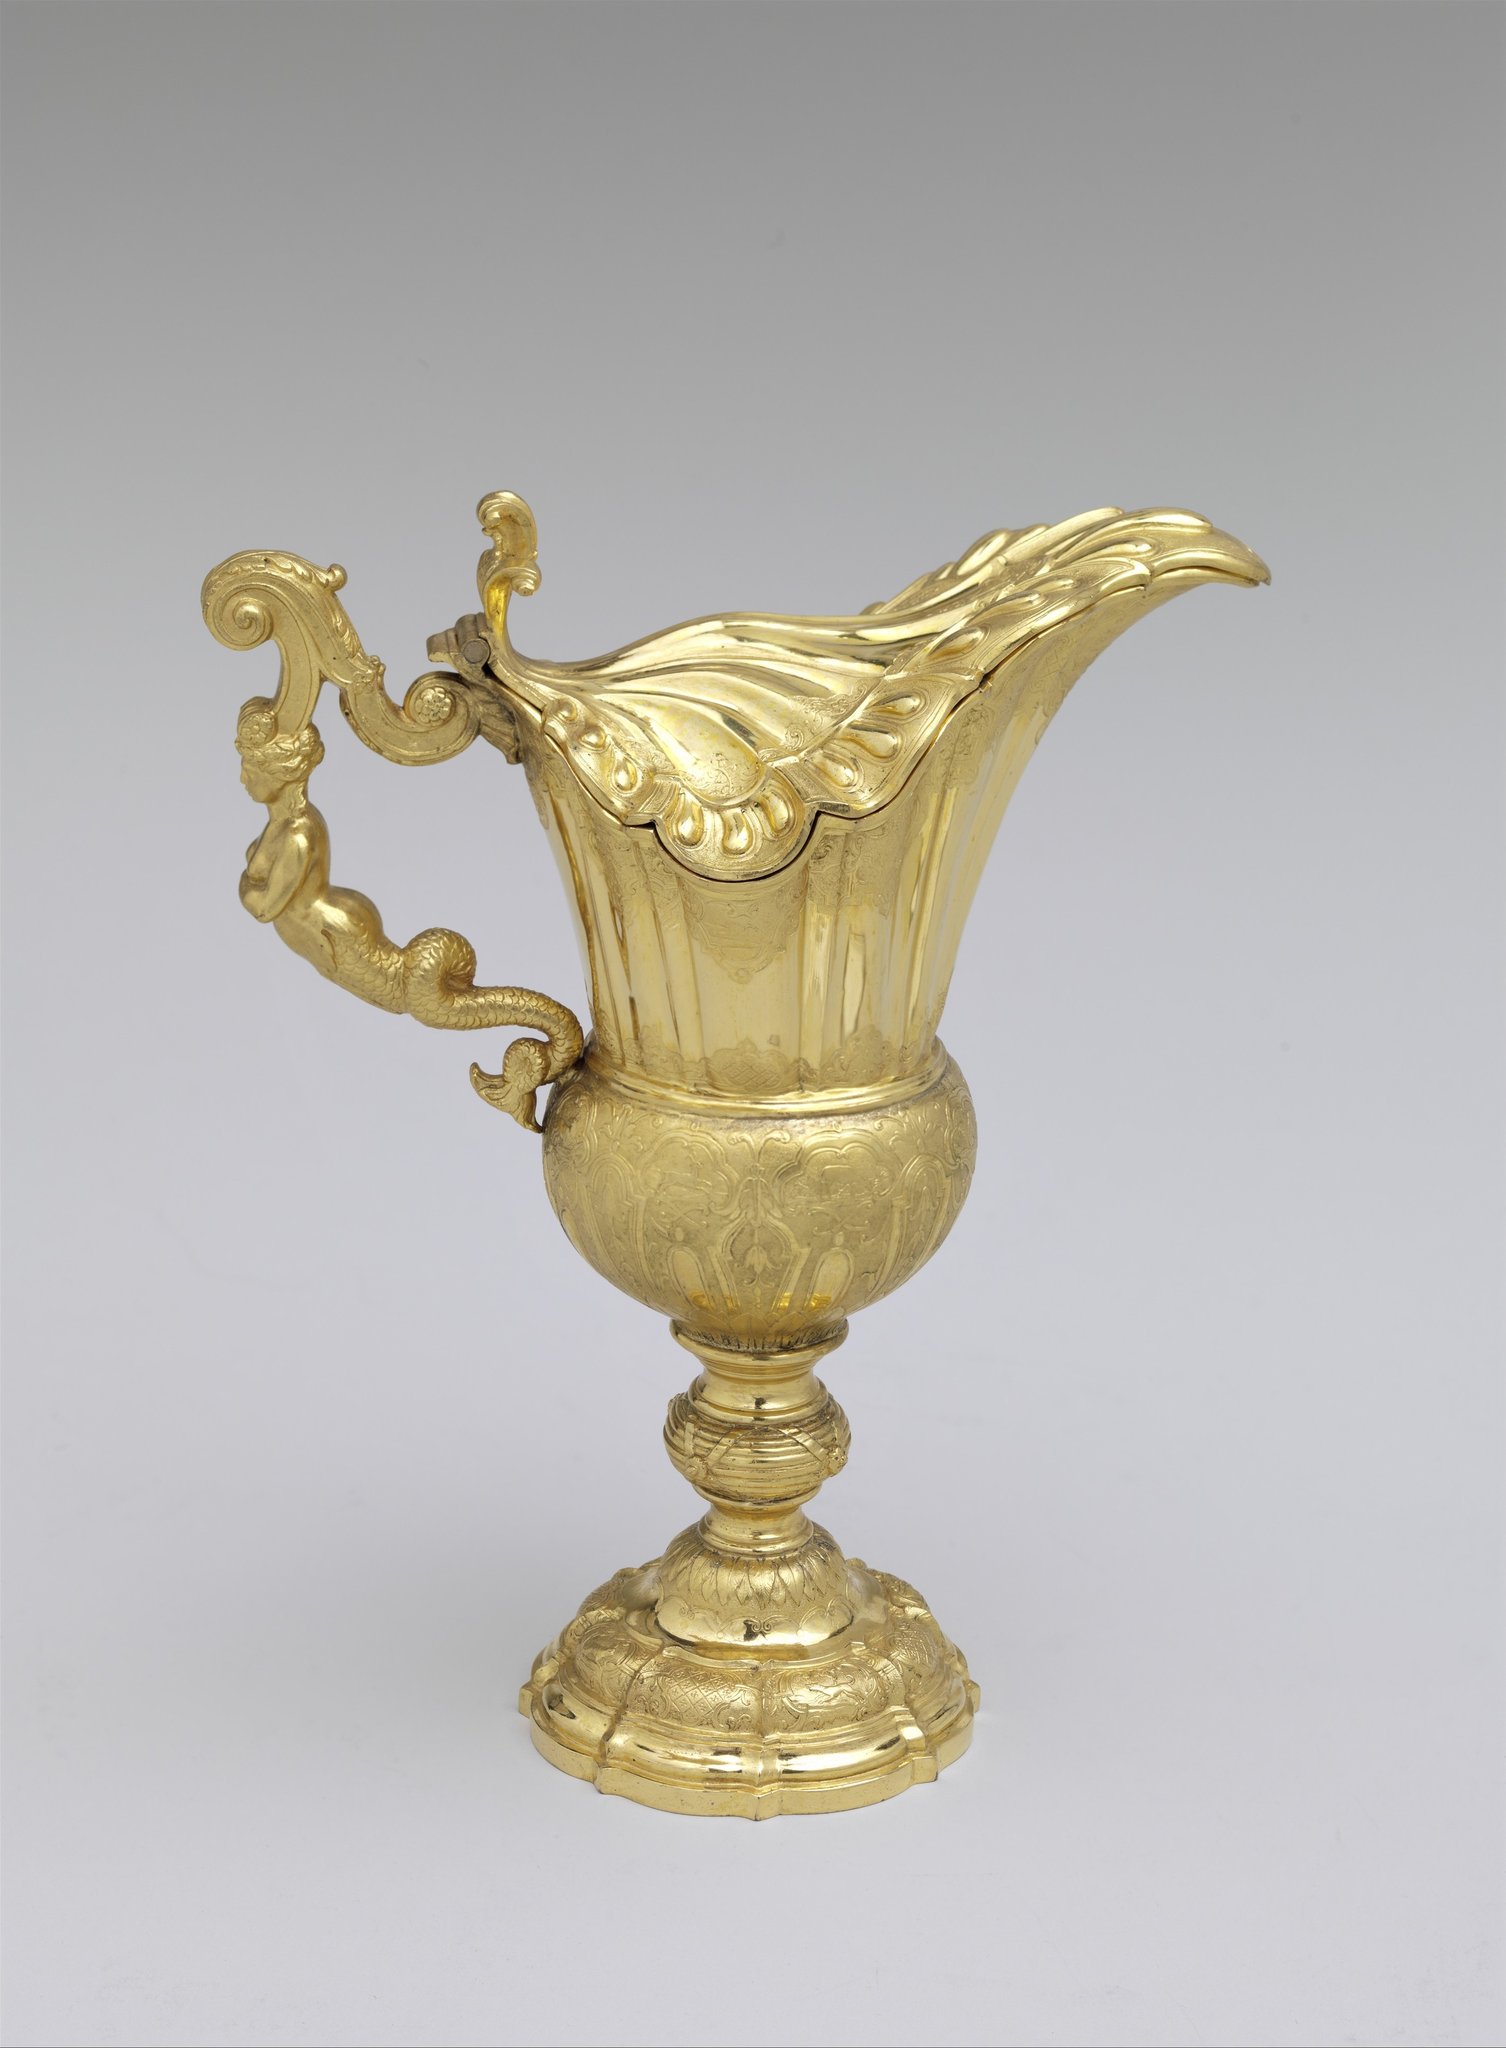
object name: ewer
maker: johann ludwig ii biller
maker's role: maker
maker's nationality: german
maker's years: 1692-1746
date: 1801-1900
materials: gold